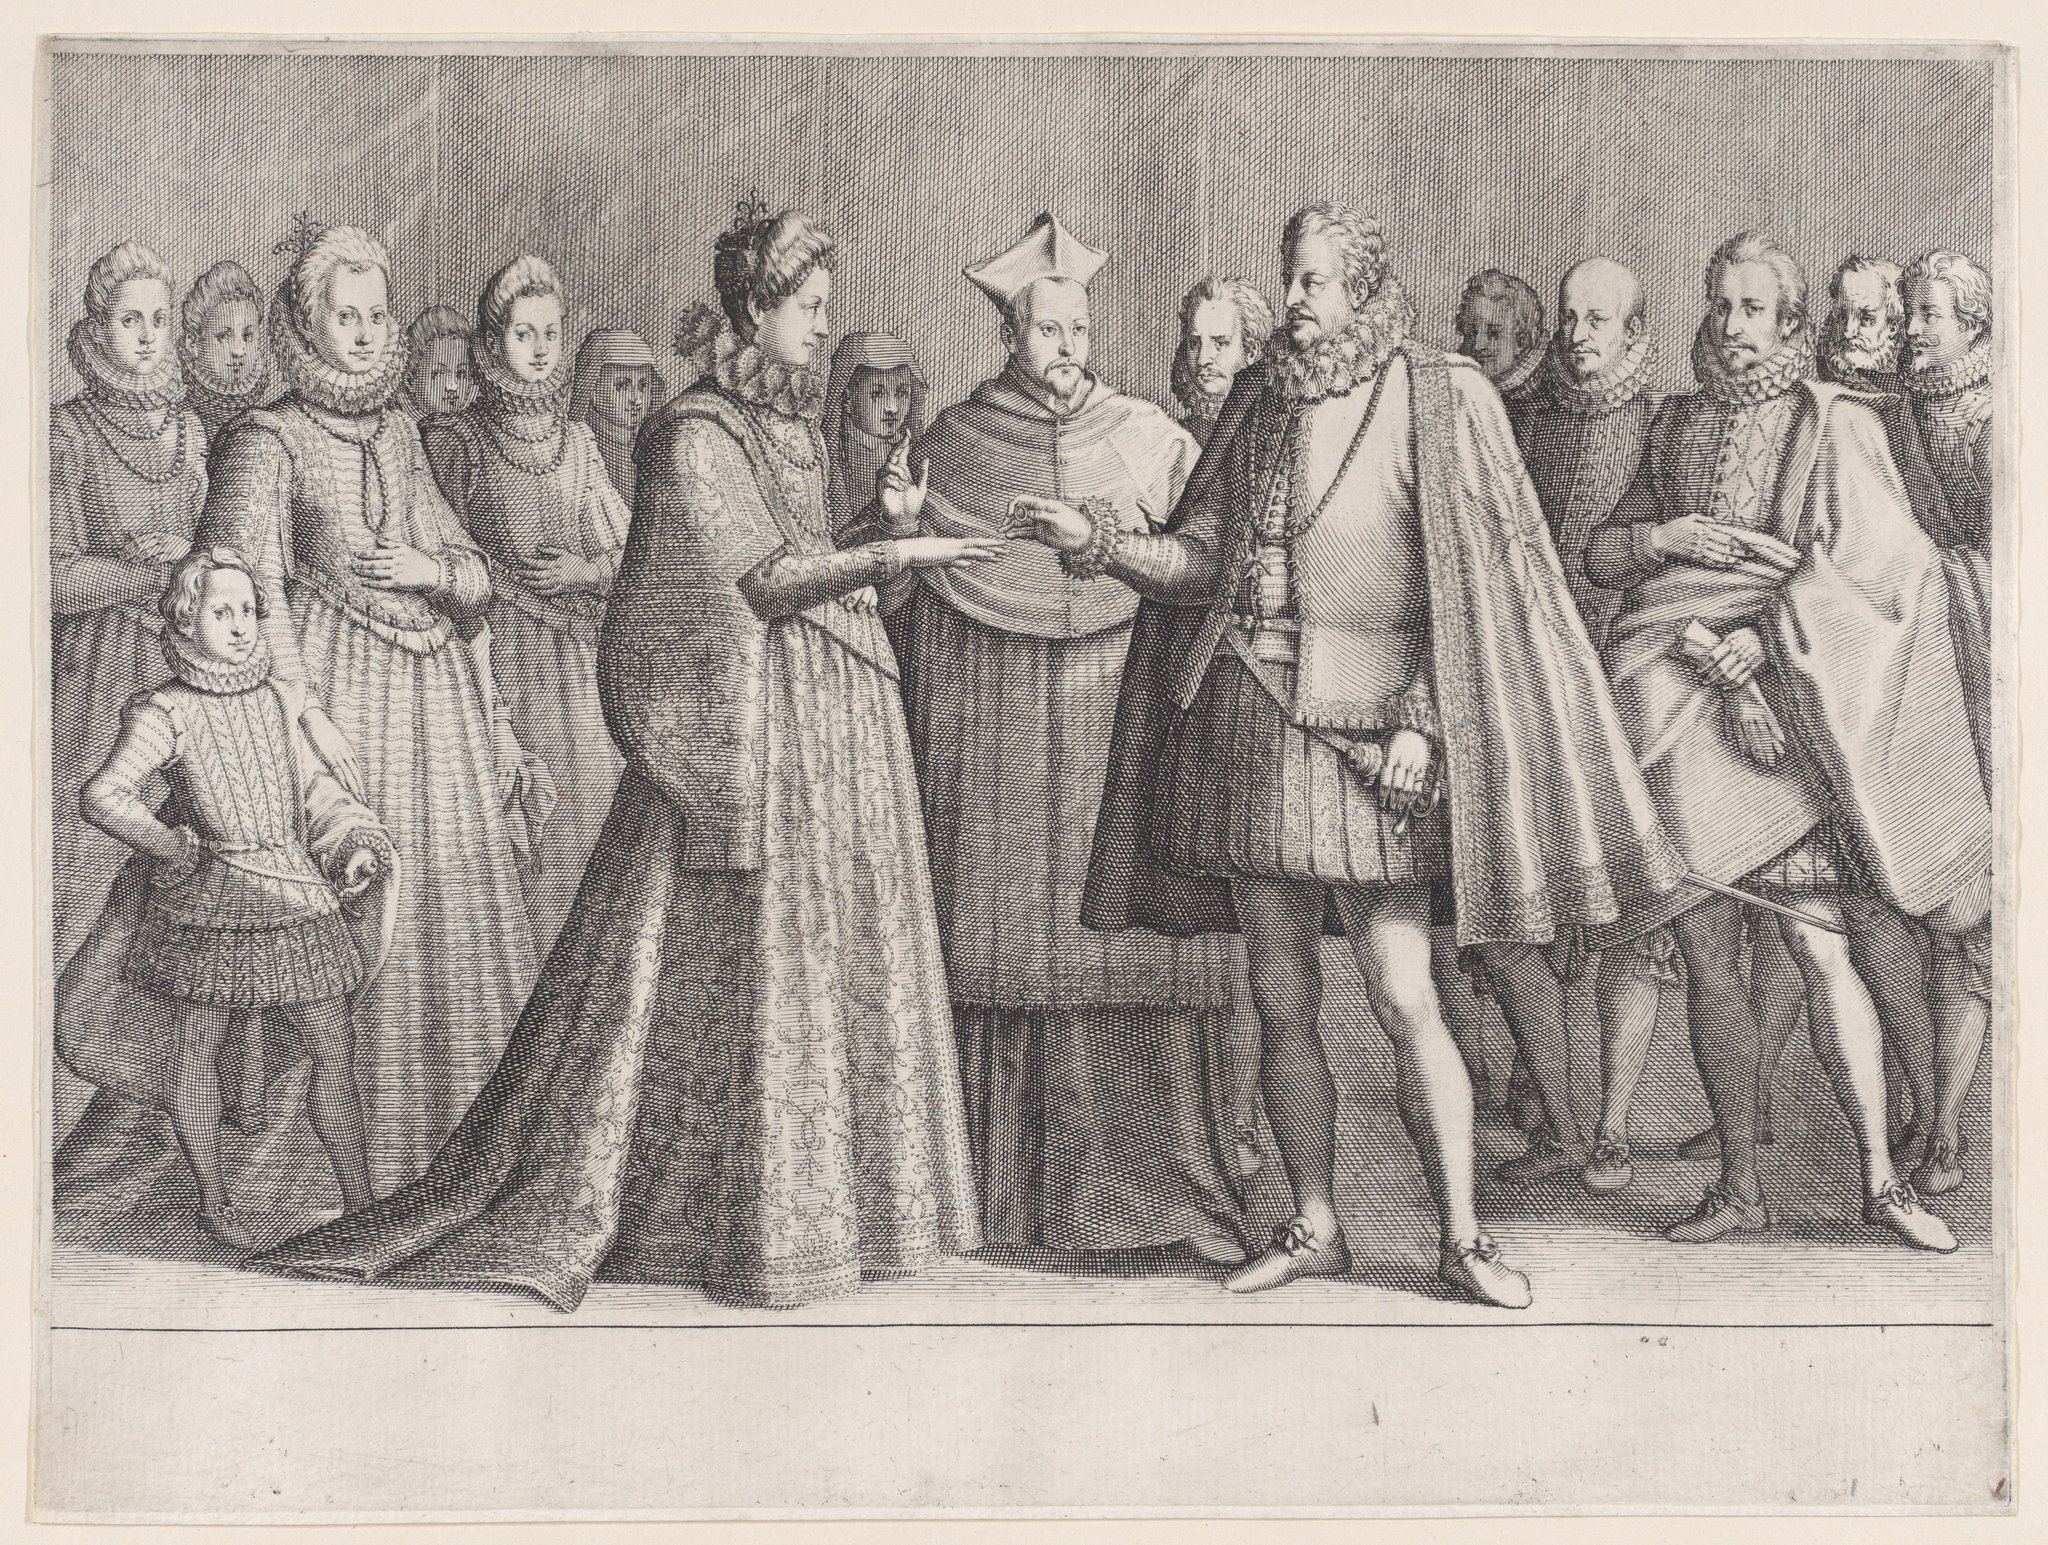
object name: print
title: Le Mariage de Ferdinand 1er (The Marriage of Ferdinand I de'Medici), from "La Vie de Ferdinand Ier de Médicis série appelée aussi Les Batailles des Médicis" (The Life of Ferdinand I de'Medici also called The Medici Battles)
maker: jacques callot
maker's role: artist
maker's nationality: french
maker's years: 1592-1635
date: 1614-1620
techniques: engraving